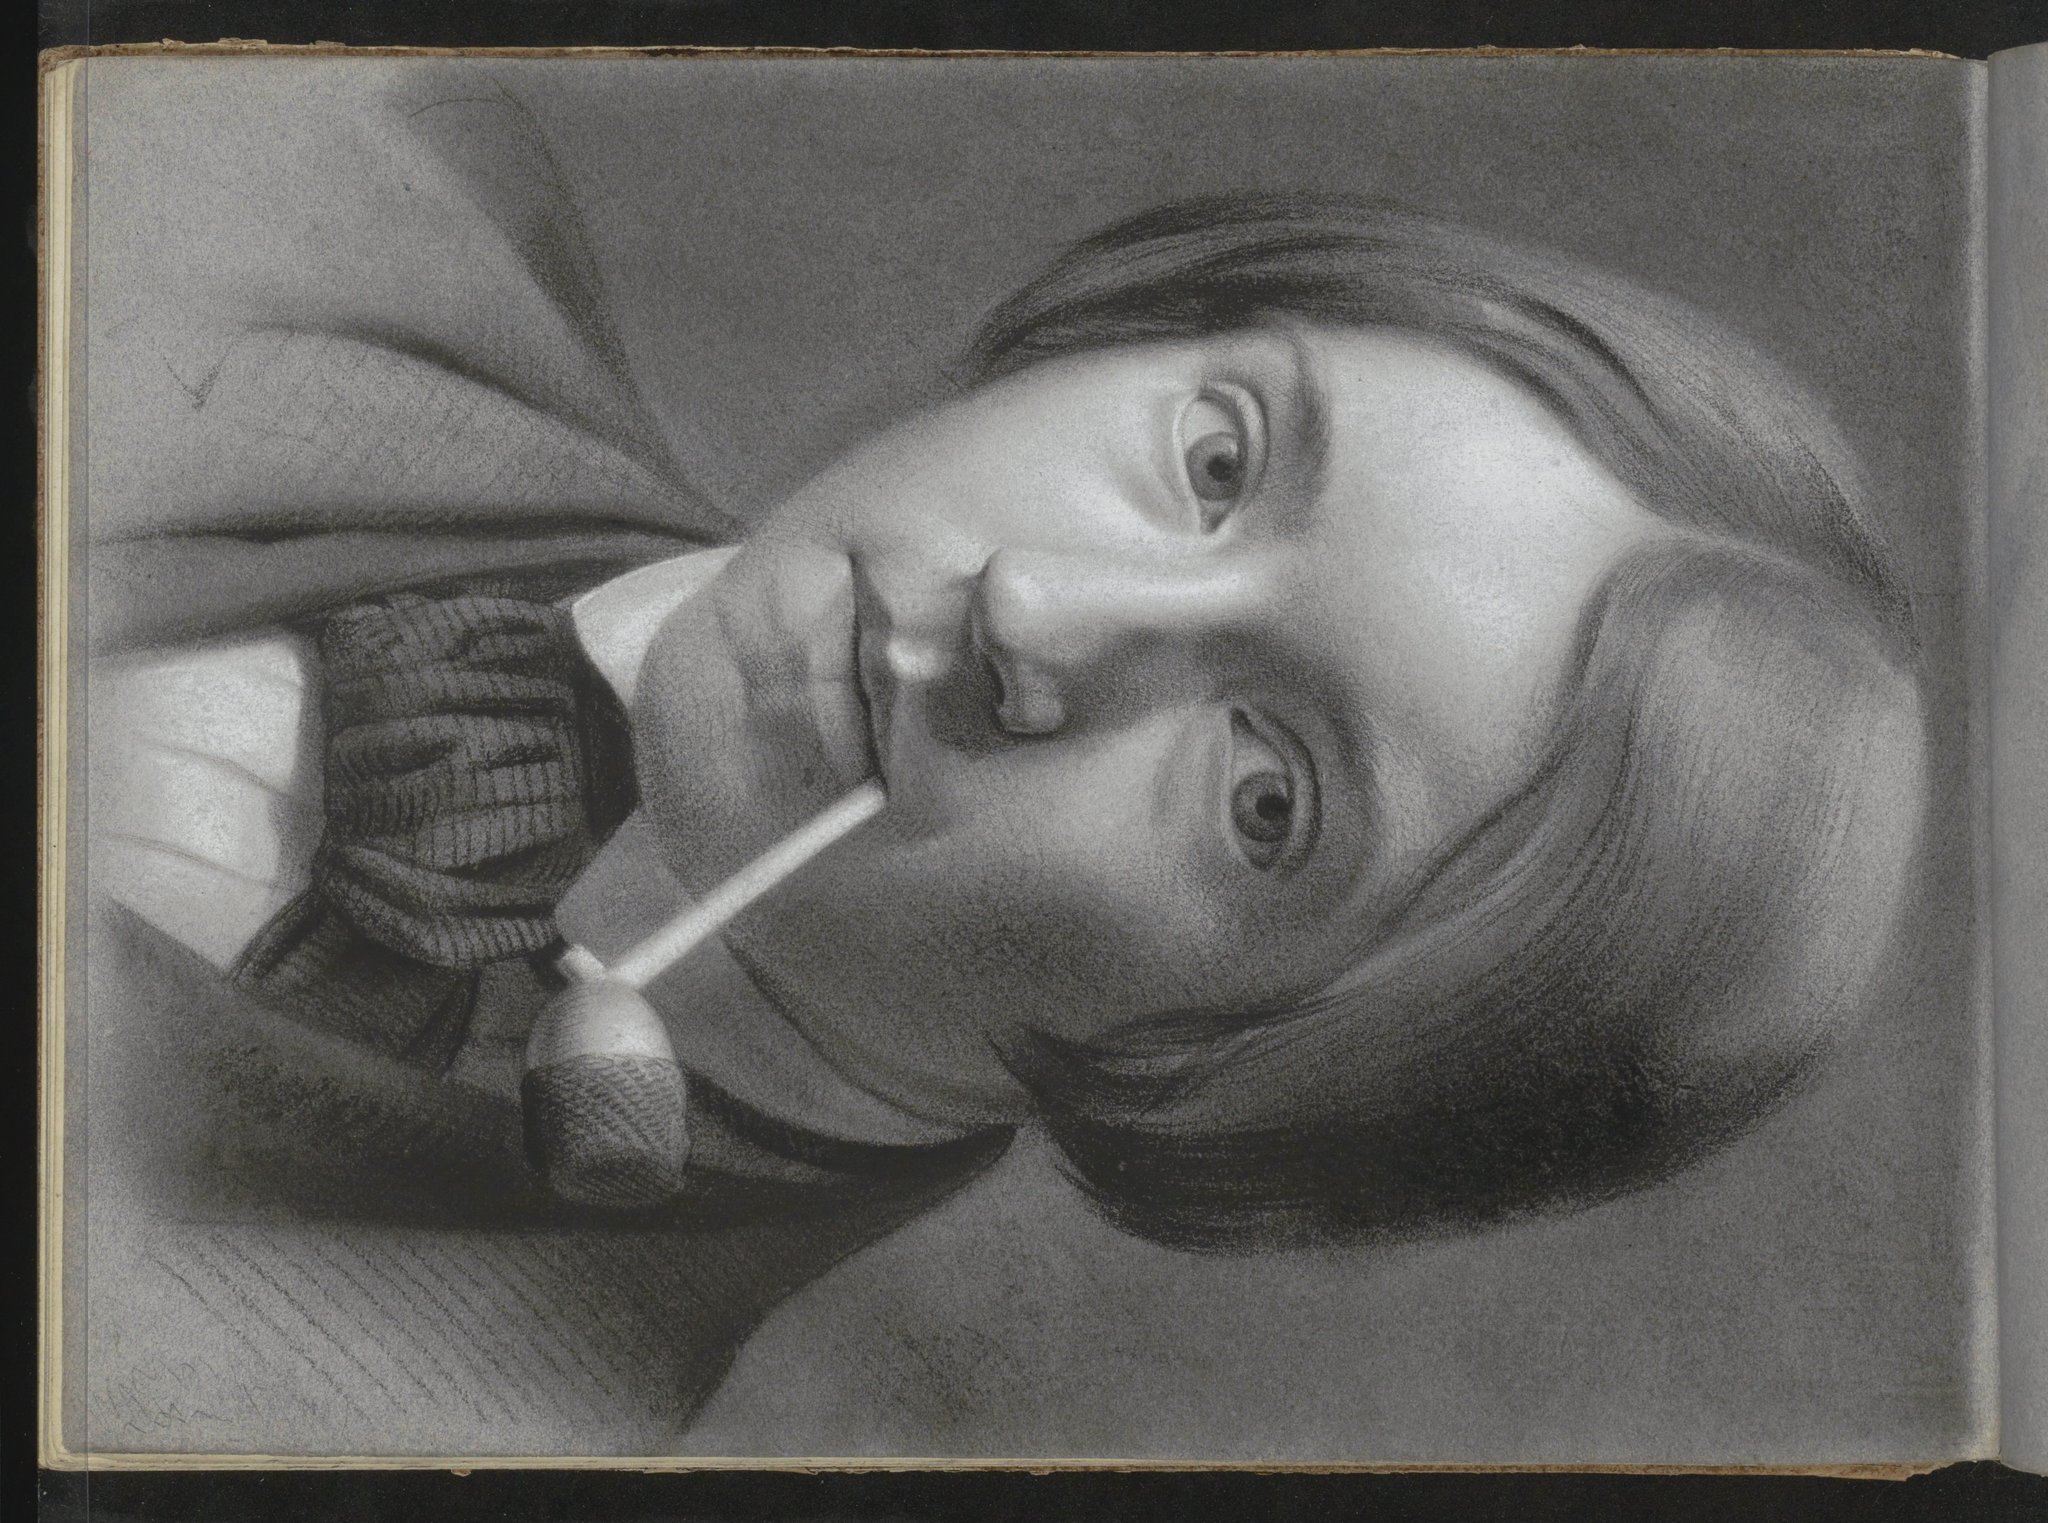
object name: sketchbook leaf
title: Portret van een jonge man met pijp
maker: s. altmann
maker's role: painter, print maker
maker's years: 1822-1890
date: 1803-1840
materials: chalk, paper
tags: pipe ~ tobacco, anonymous historical person portrayed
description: Blad 15 verso uit een schetsboek met 24 bladen.